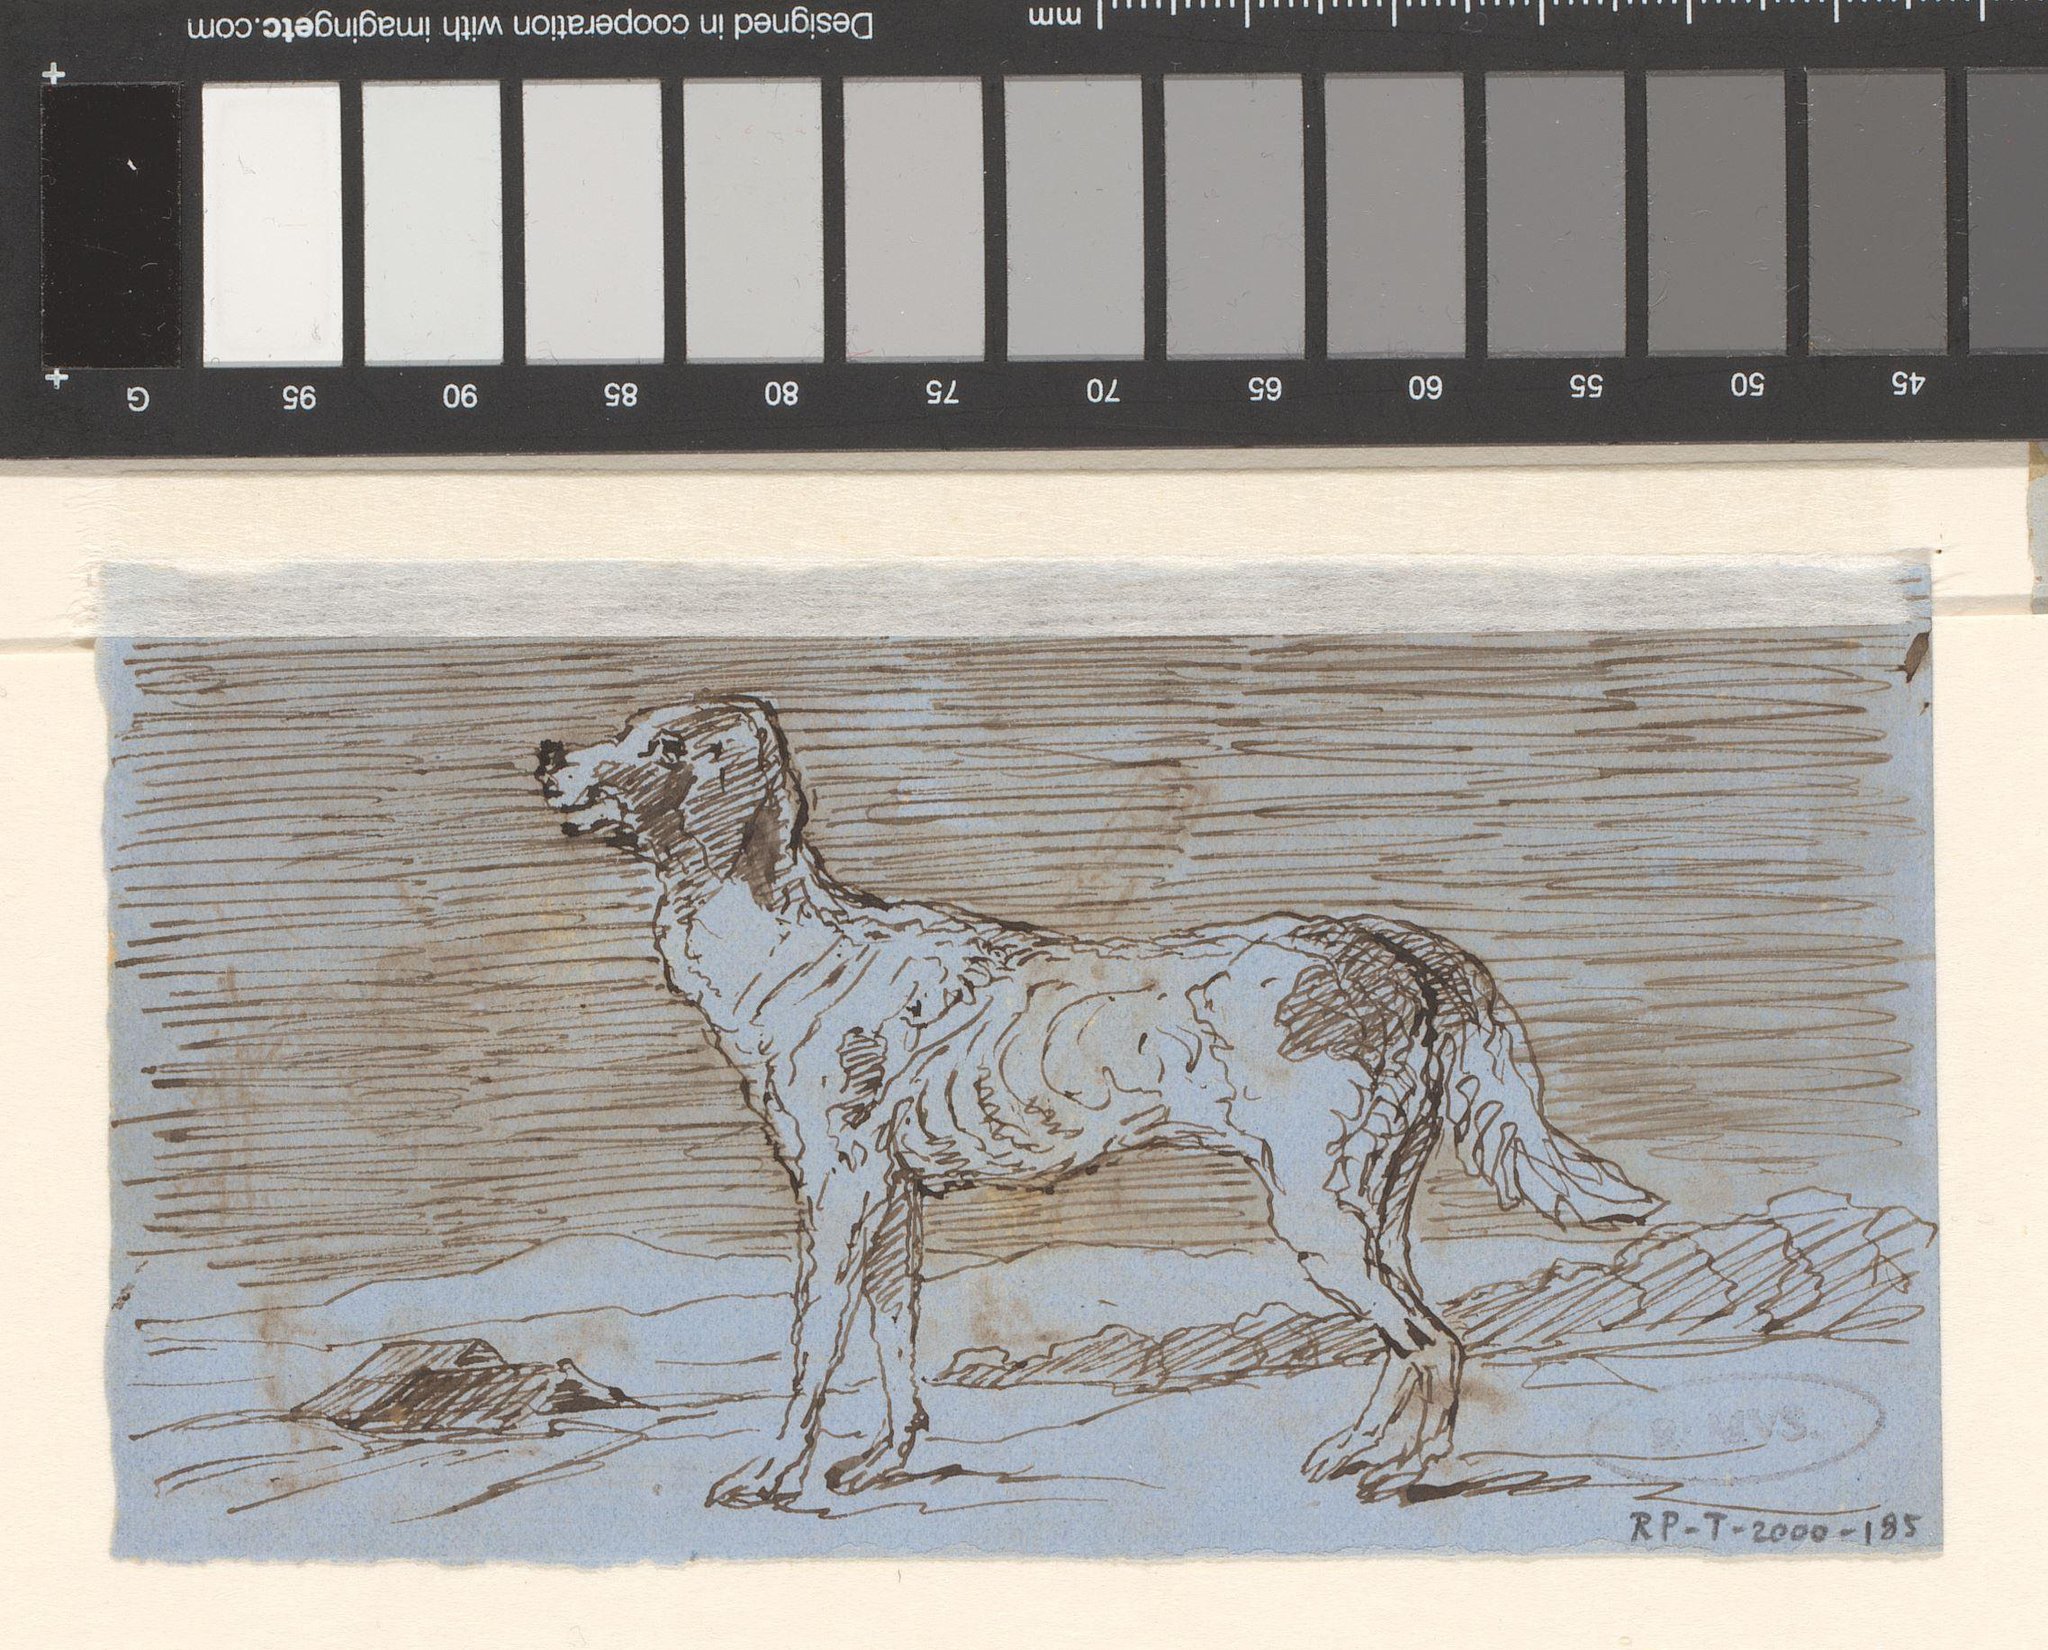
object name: drawing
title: Jachthond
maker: johannes tavenraat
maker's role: draughtsman, painter, print maker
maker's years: 1809-1881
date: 1840-1880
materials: ink, paper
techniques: pen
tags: hunting dogs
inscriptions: collector's mark: Lugt 2228